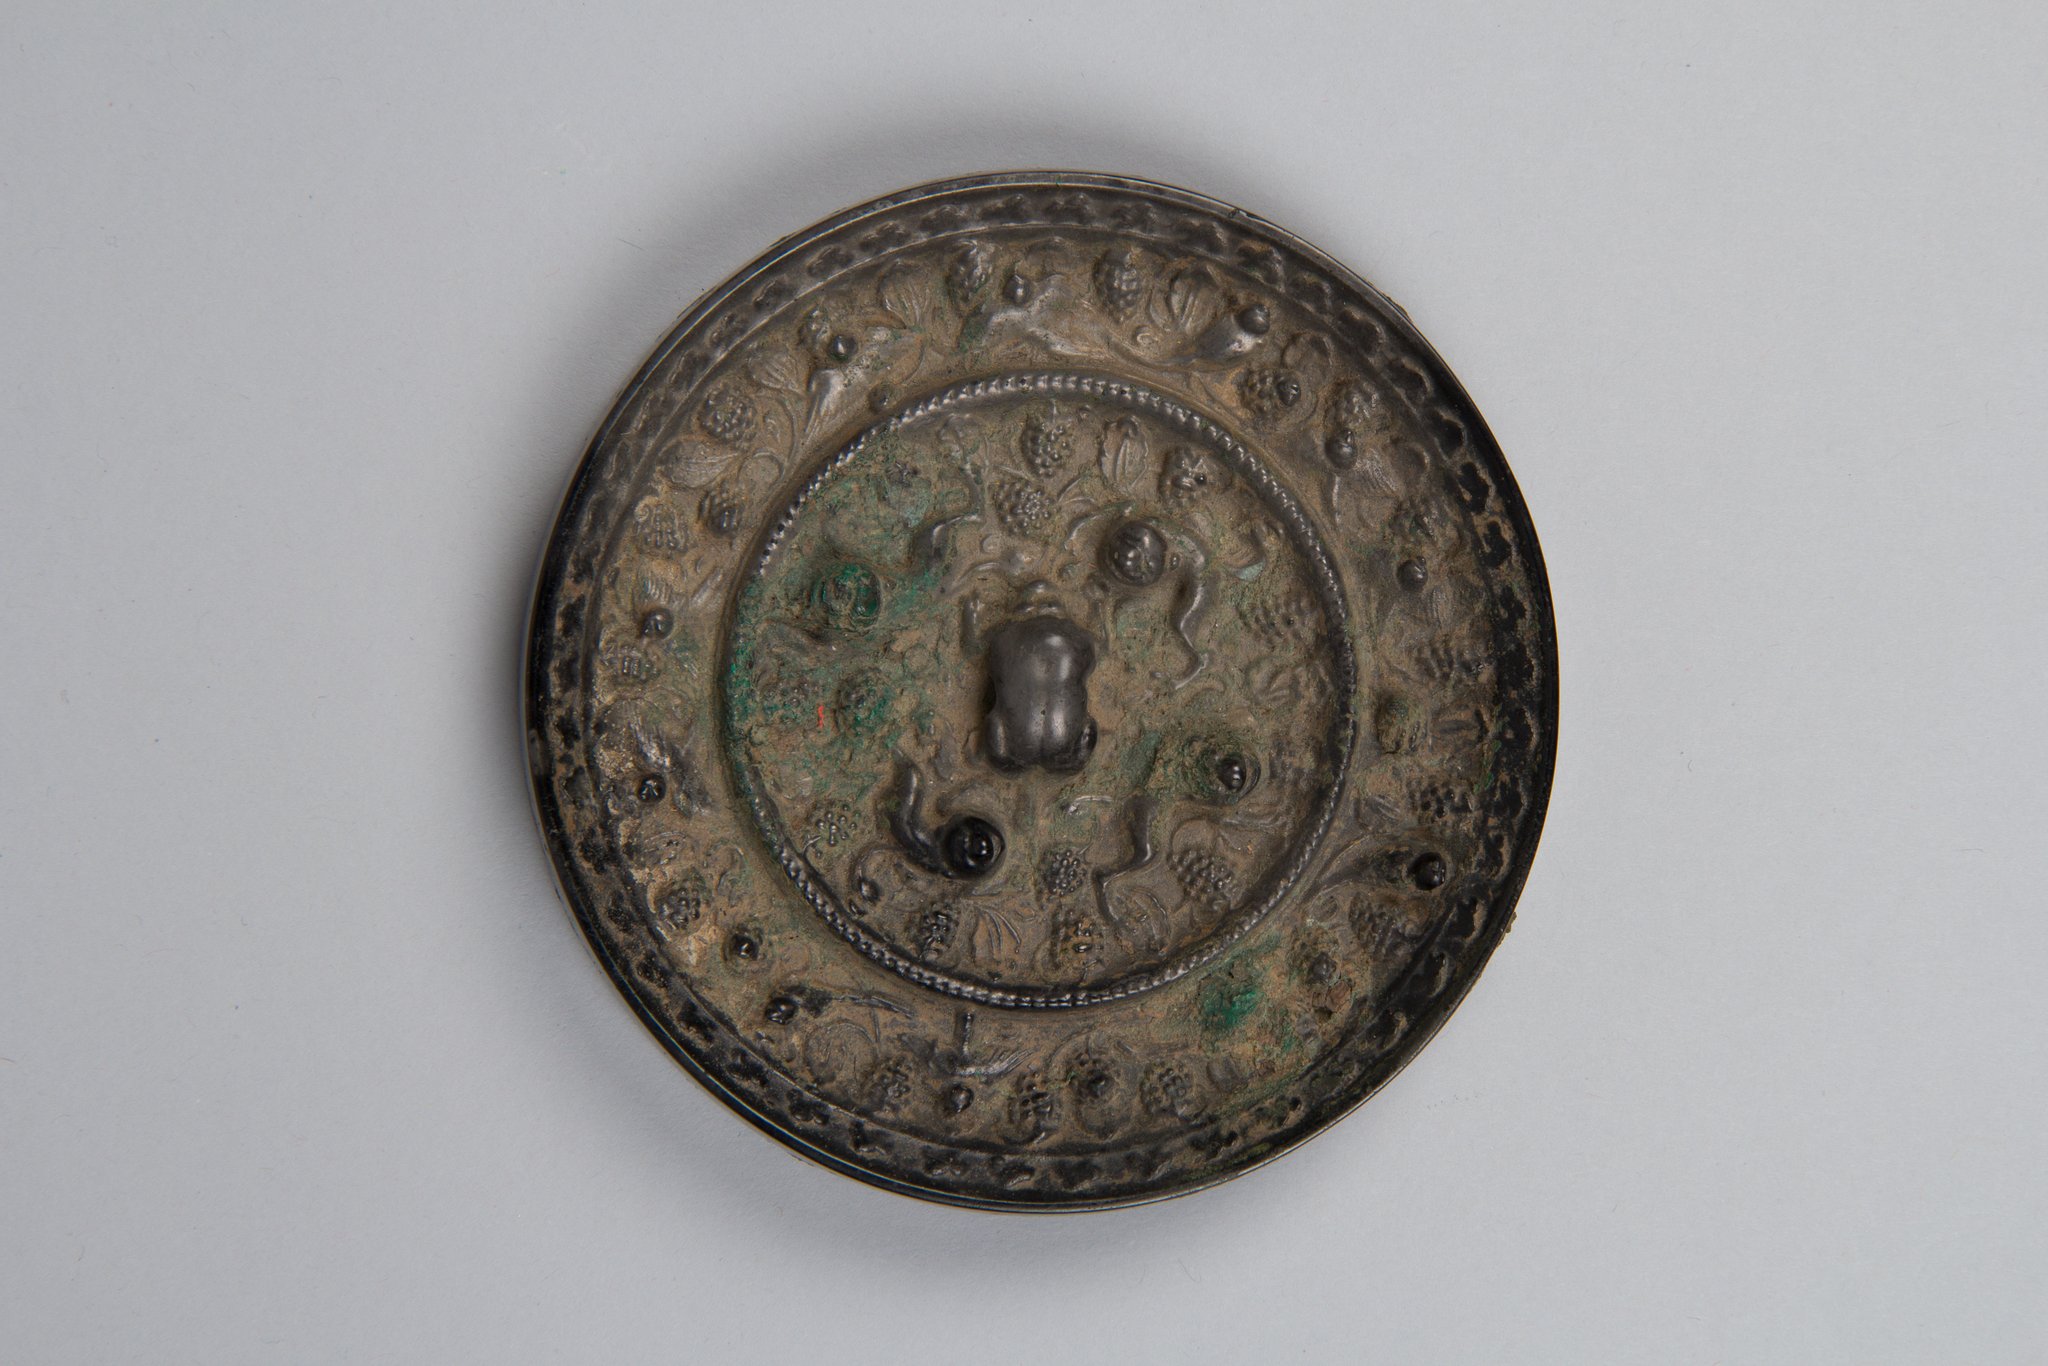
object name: mirror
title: Mirror with fantastic animals amid grape vines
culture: chinese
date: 601-800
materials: bronze, patina, silver